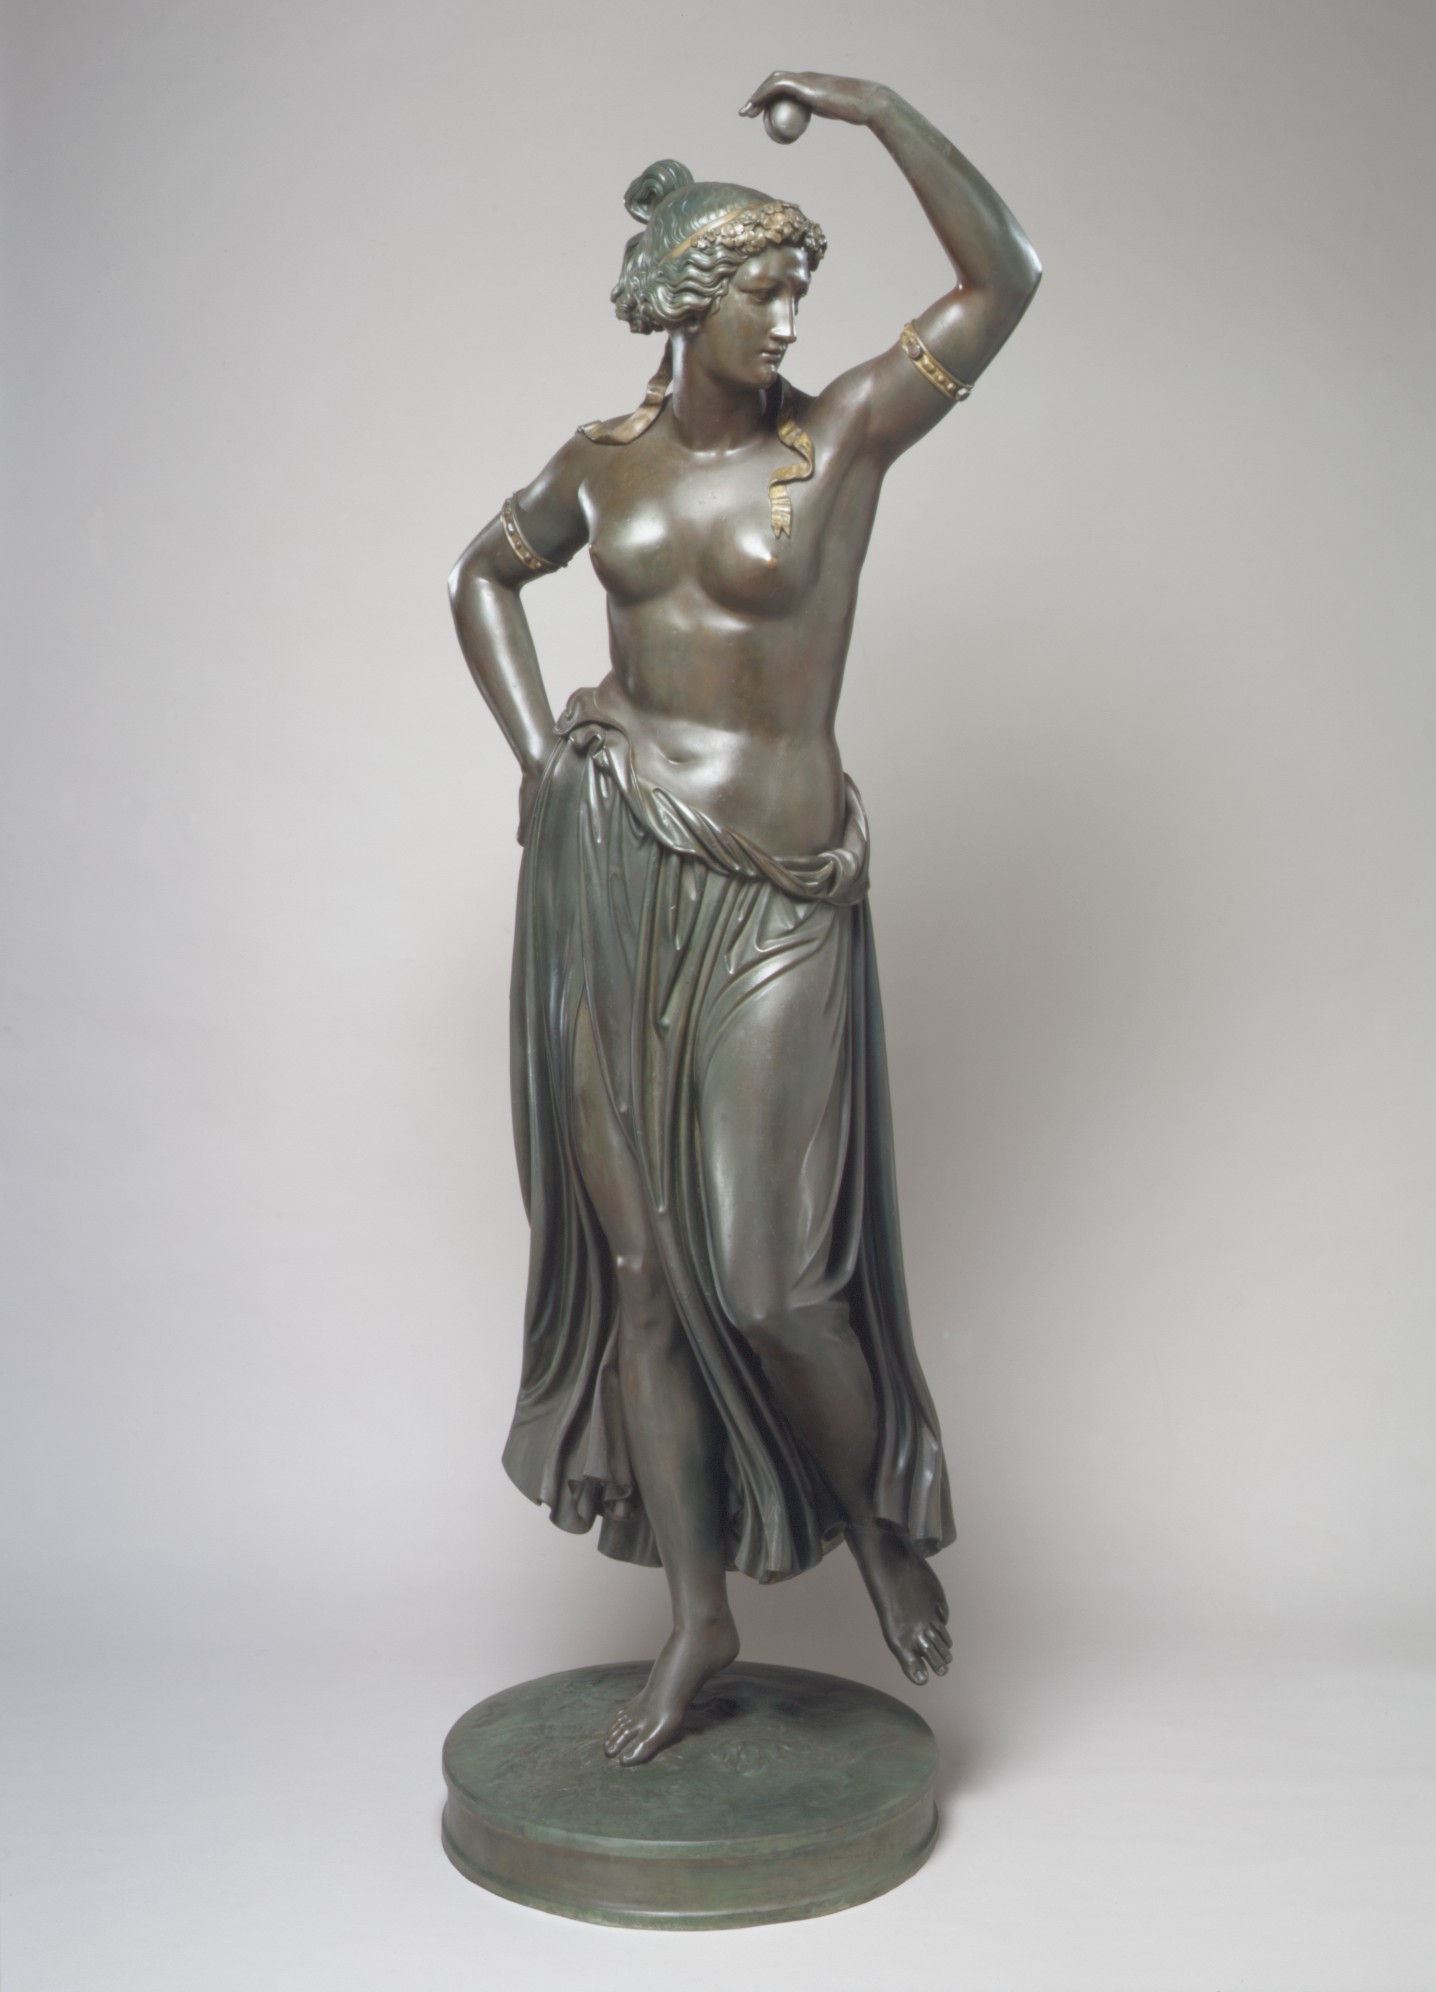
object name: statue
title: Dancing Girl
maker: ludwig michael von schwanthaler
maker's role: artist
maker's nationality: german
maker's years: 1802-1848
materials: bronze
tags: girls,female nudes,dancing